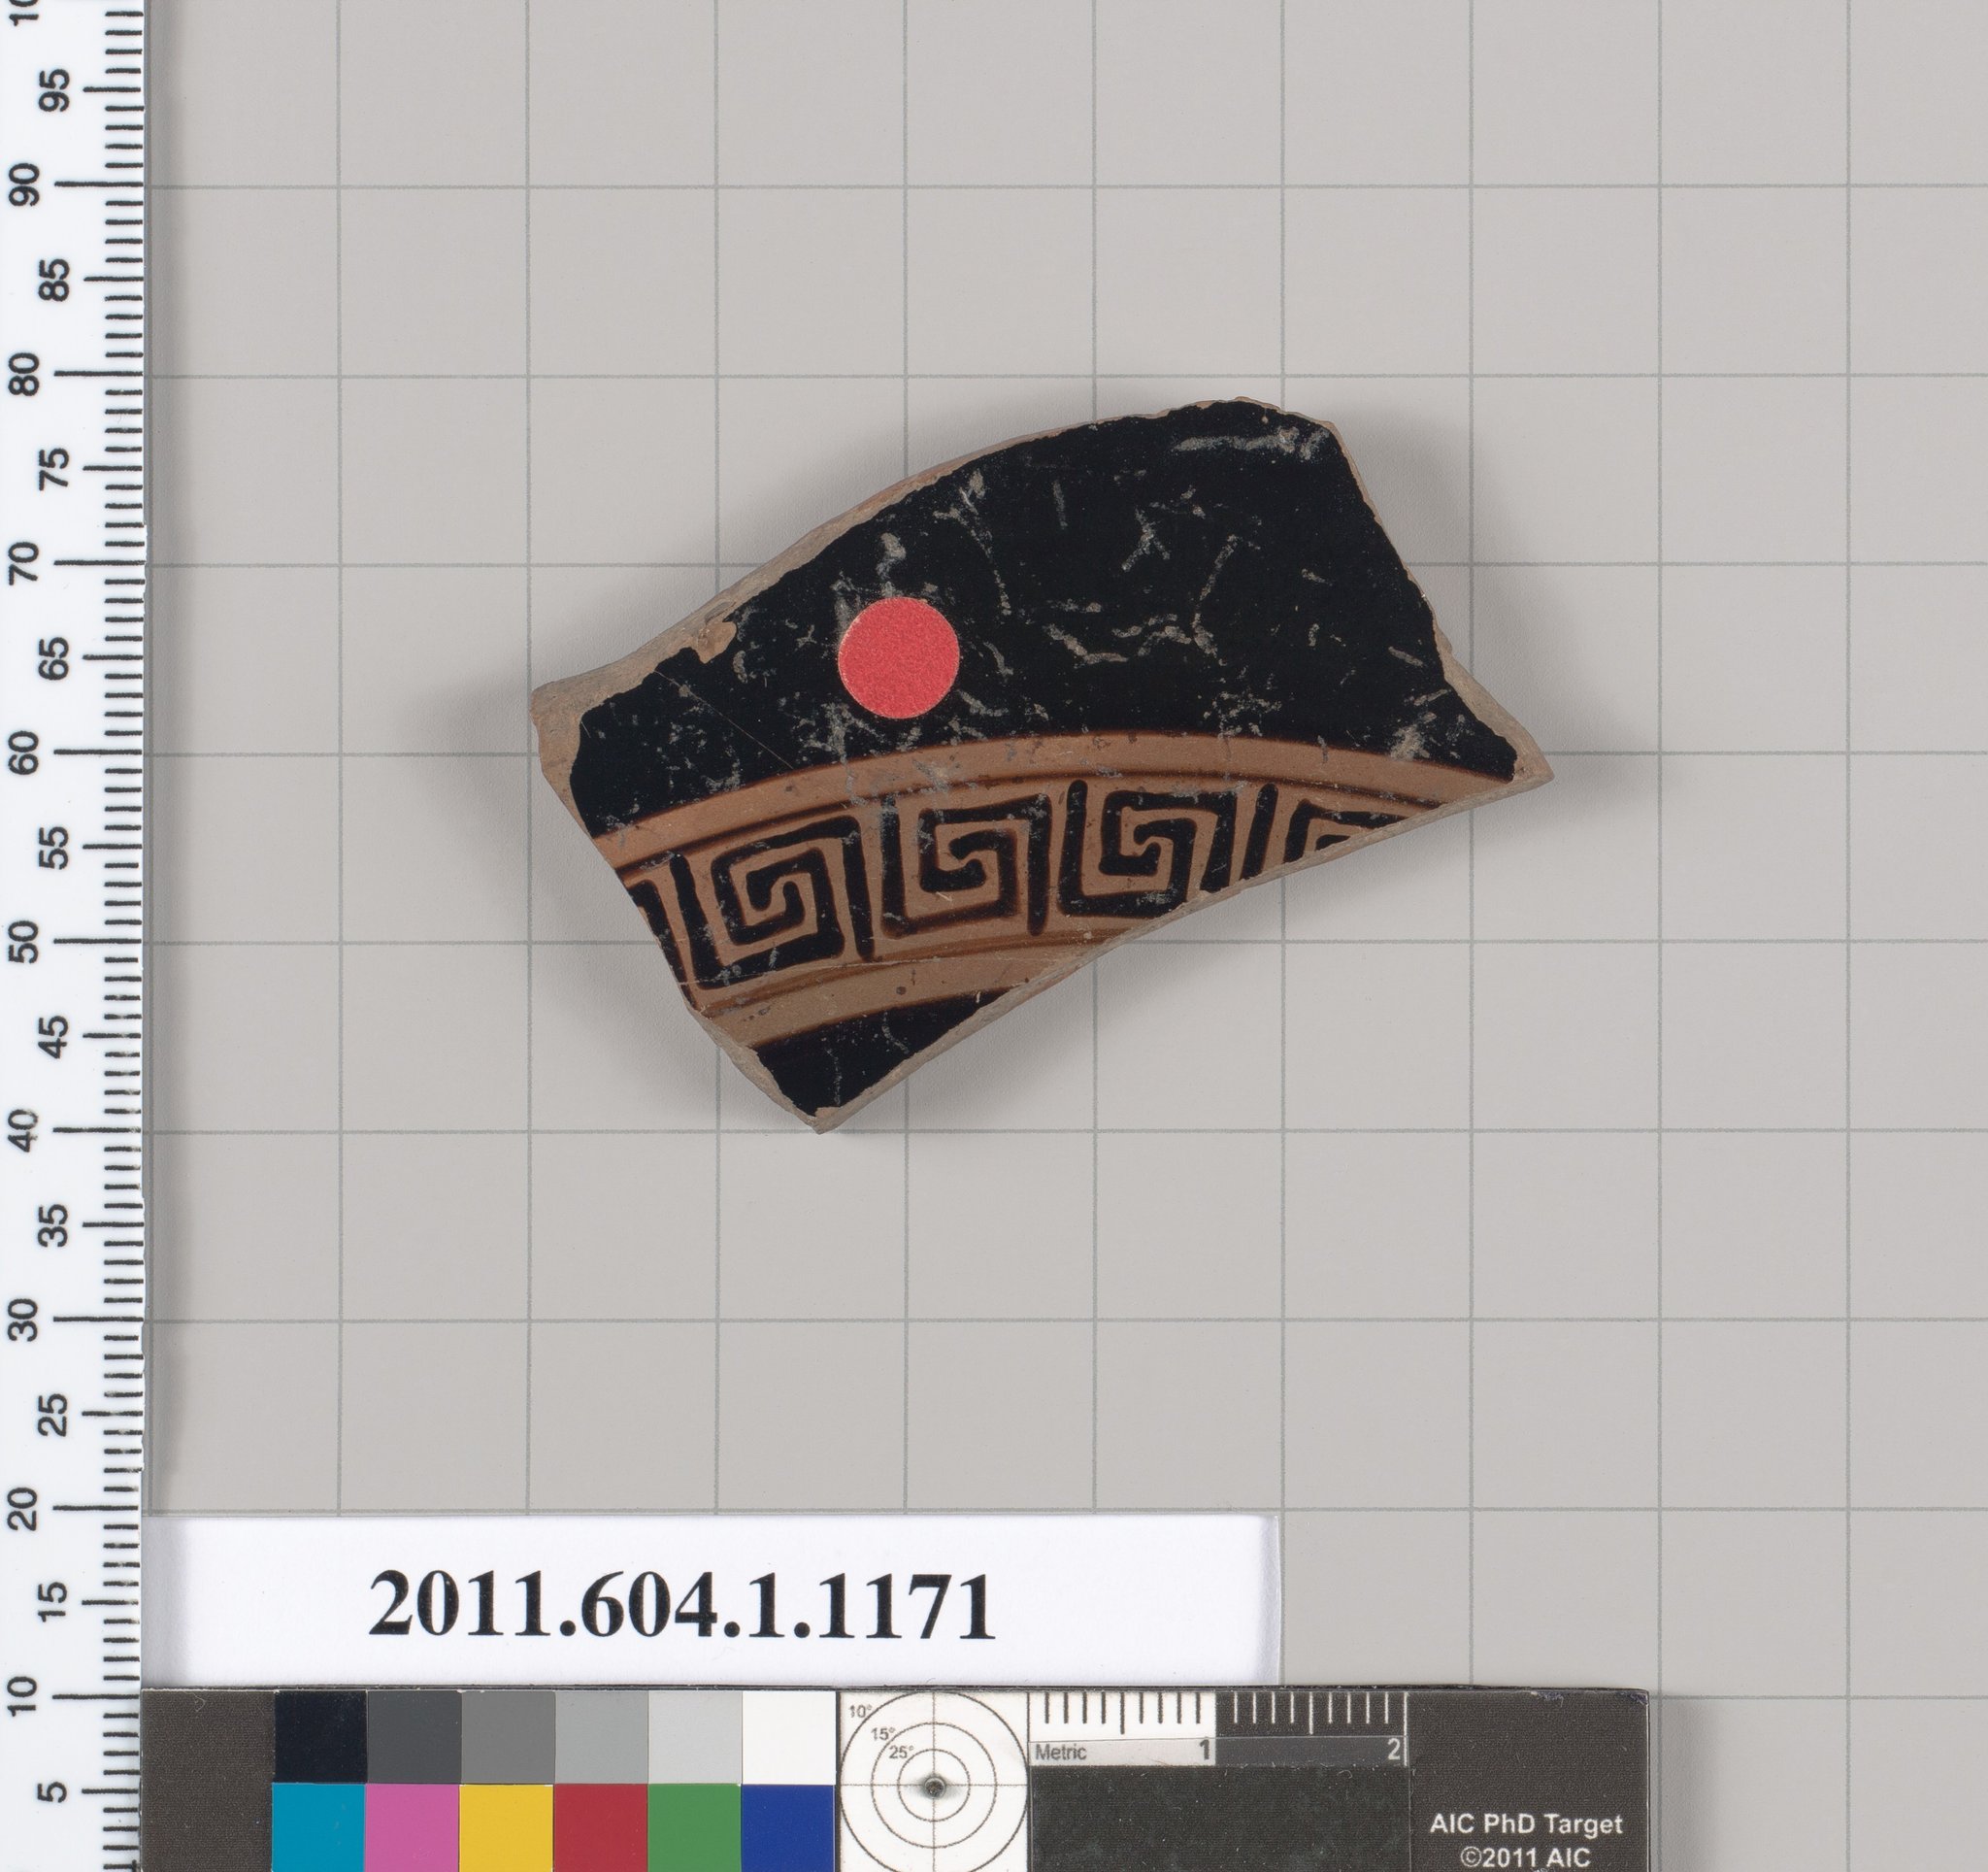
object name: kylix fragment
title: Terracotta fragment of a kylix (drinking cup)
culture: greek, attic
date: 490-480 BCE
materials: terracotta